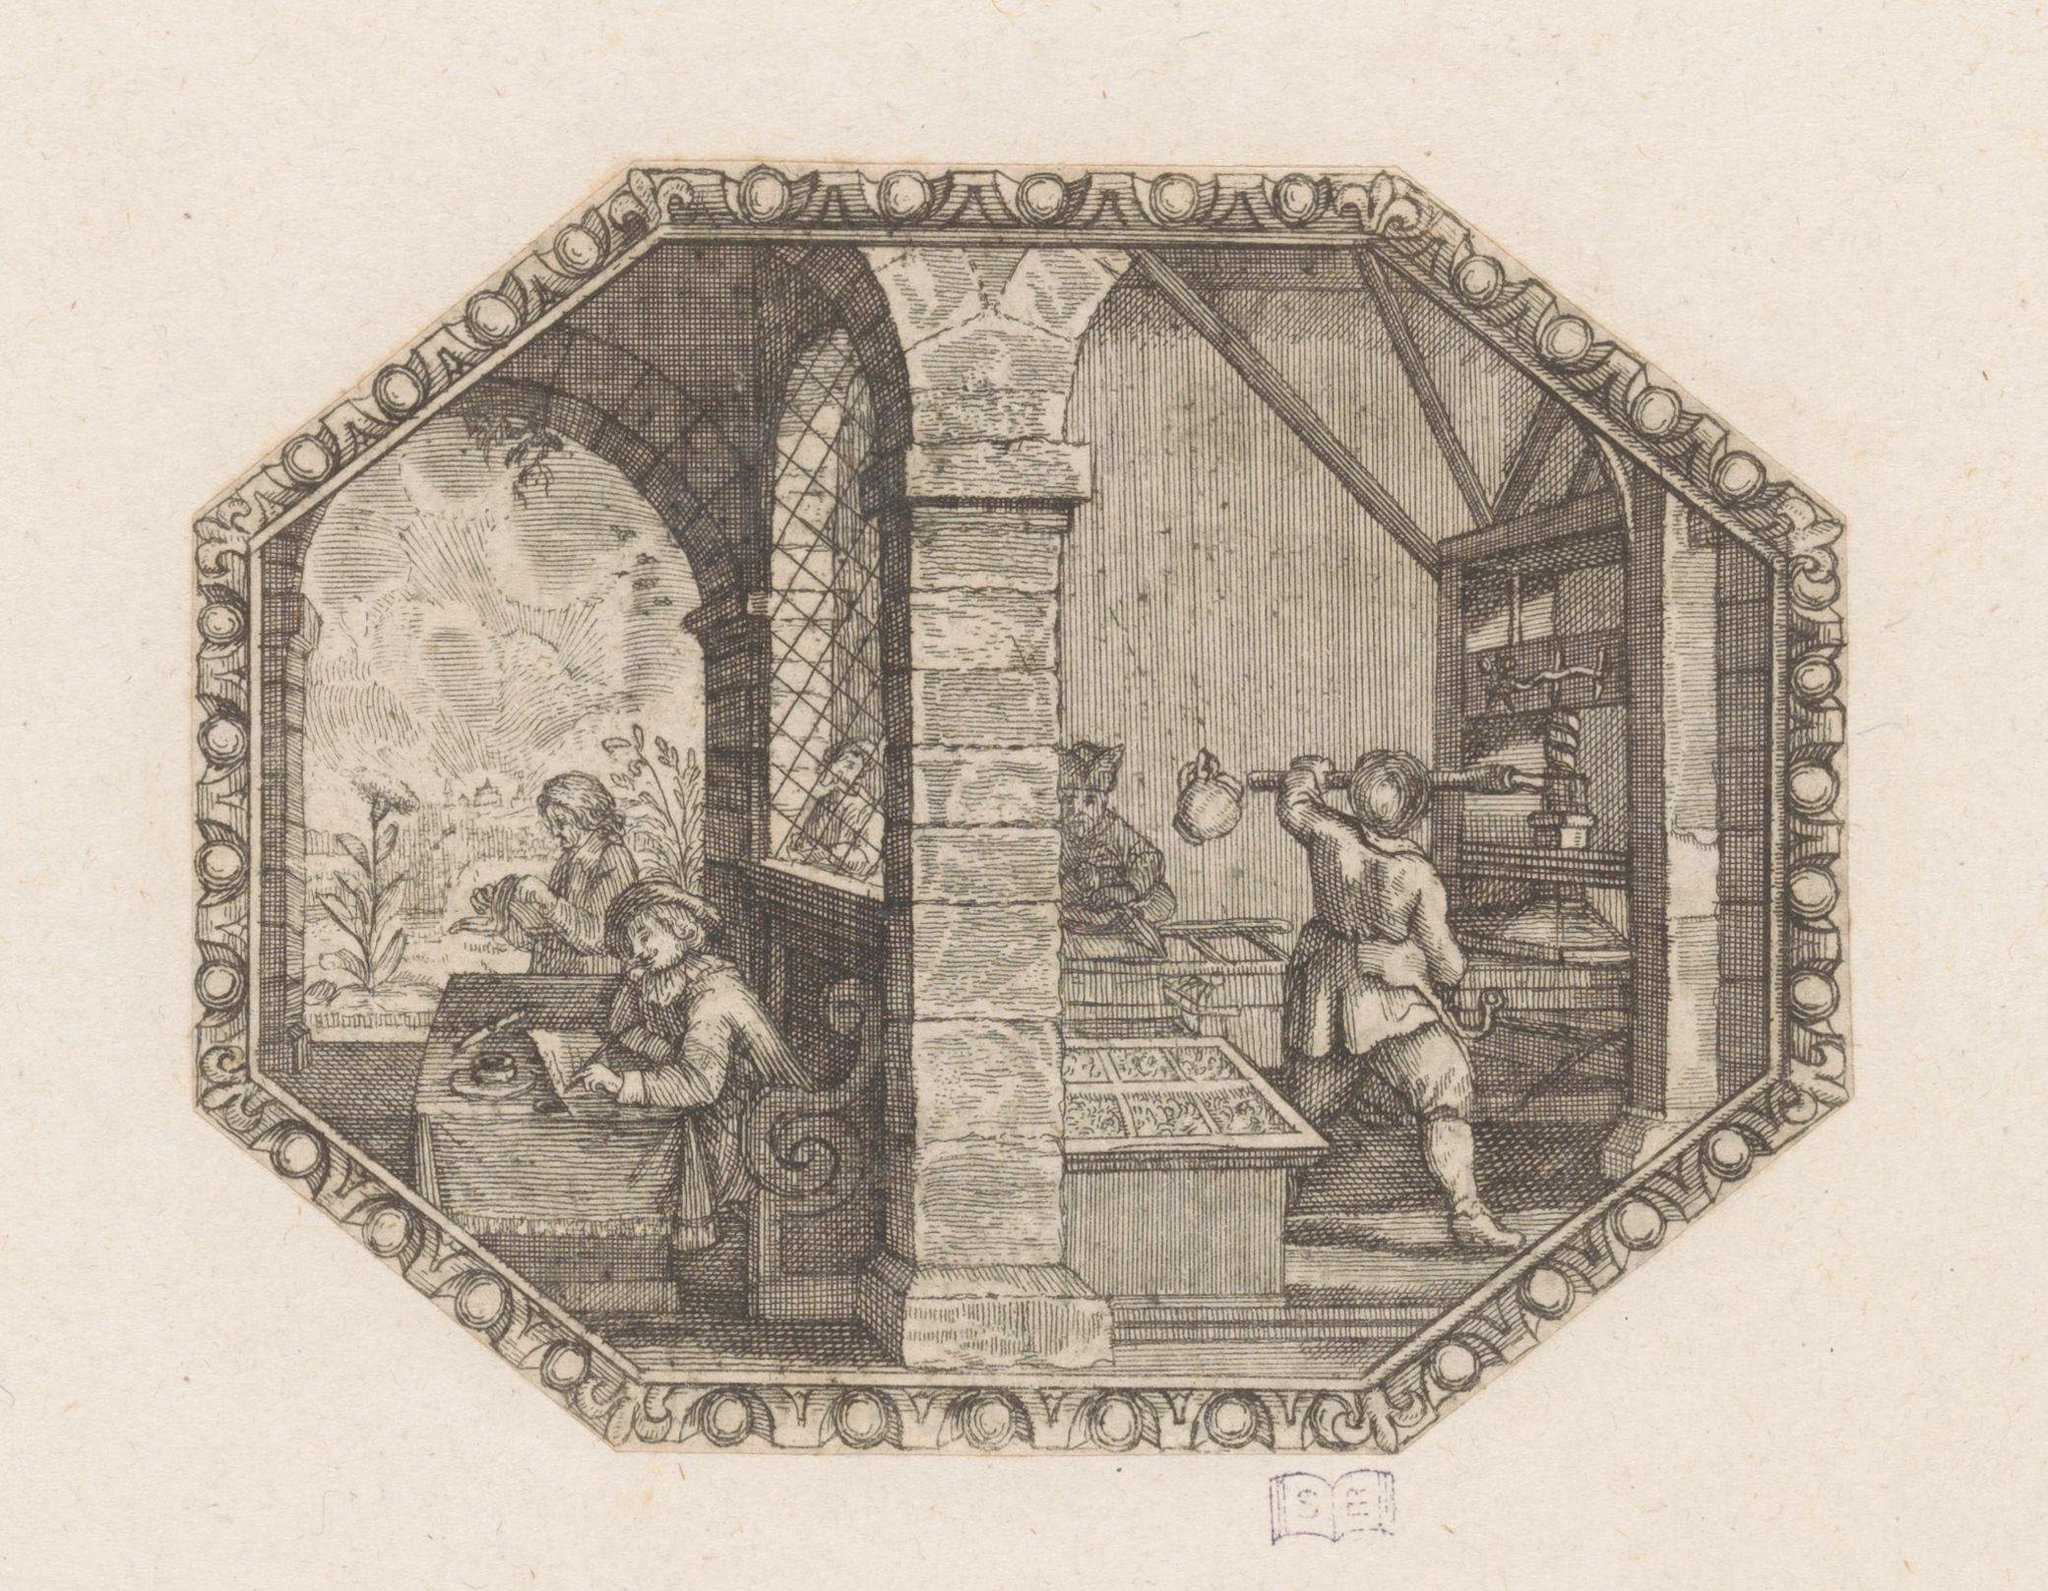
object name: print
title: Boekdrukkerij en een schrijvende man in een achthoekige omlijsting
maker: Anonymous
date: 1600-1699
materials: paper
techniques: etching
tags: writing-table, writing-desk, printing press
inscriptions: collector's mark: Lugt 4779, collector's mark: Lugt 2228, collector's mark: Lugt 2690, collector's mark: Lugt 4780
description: Interieur van een boekdrukkerij met een man die een drukpers bedient. Op de voorgrond staat een letterkist. Een muur met een getralied venster scheidt de boekdrukkerij van een schrijvende man achter een tafel.